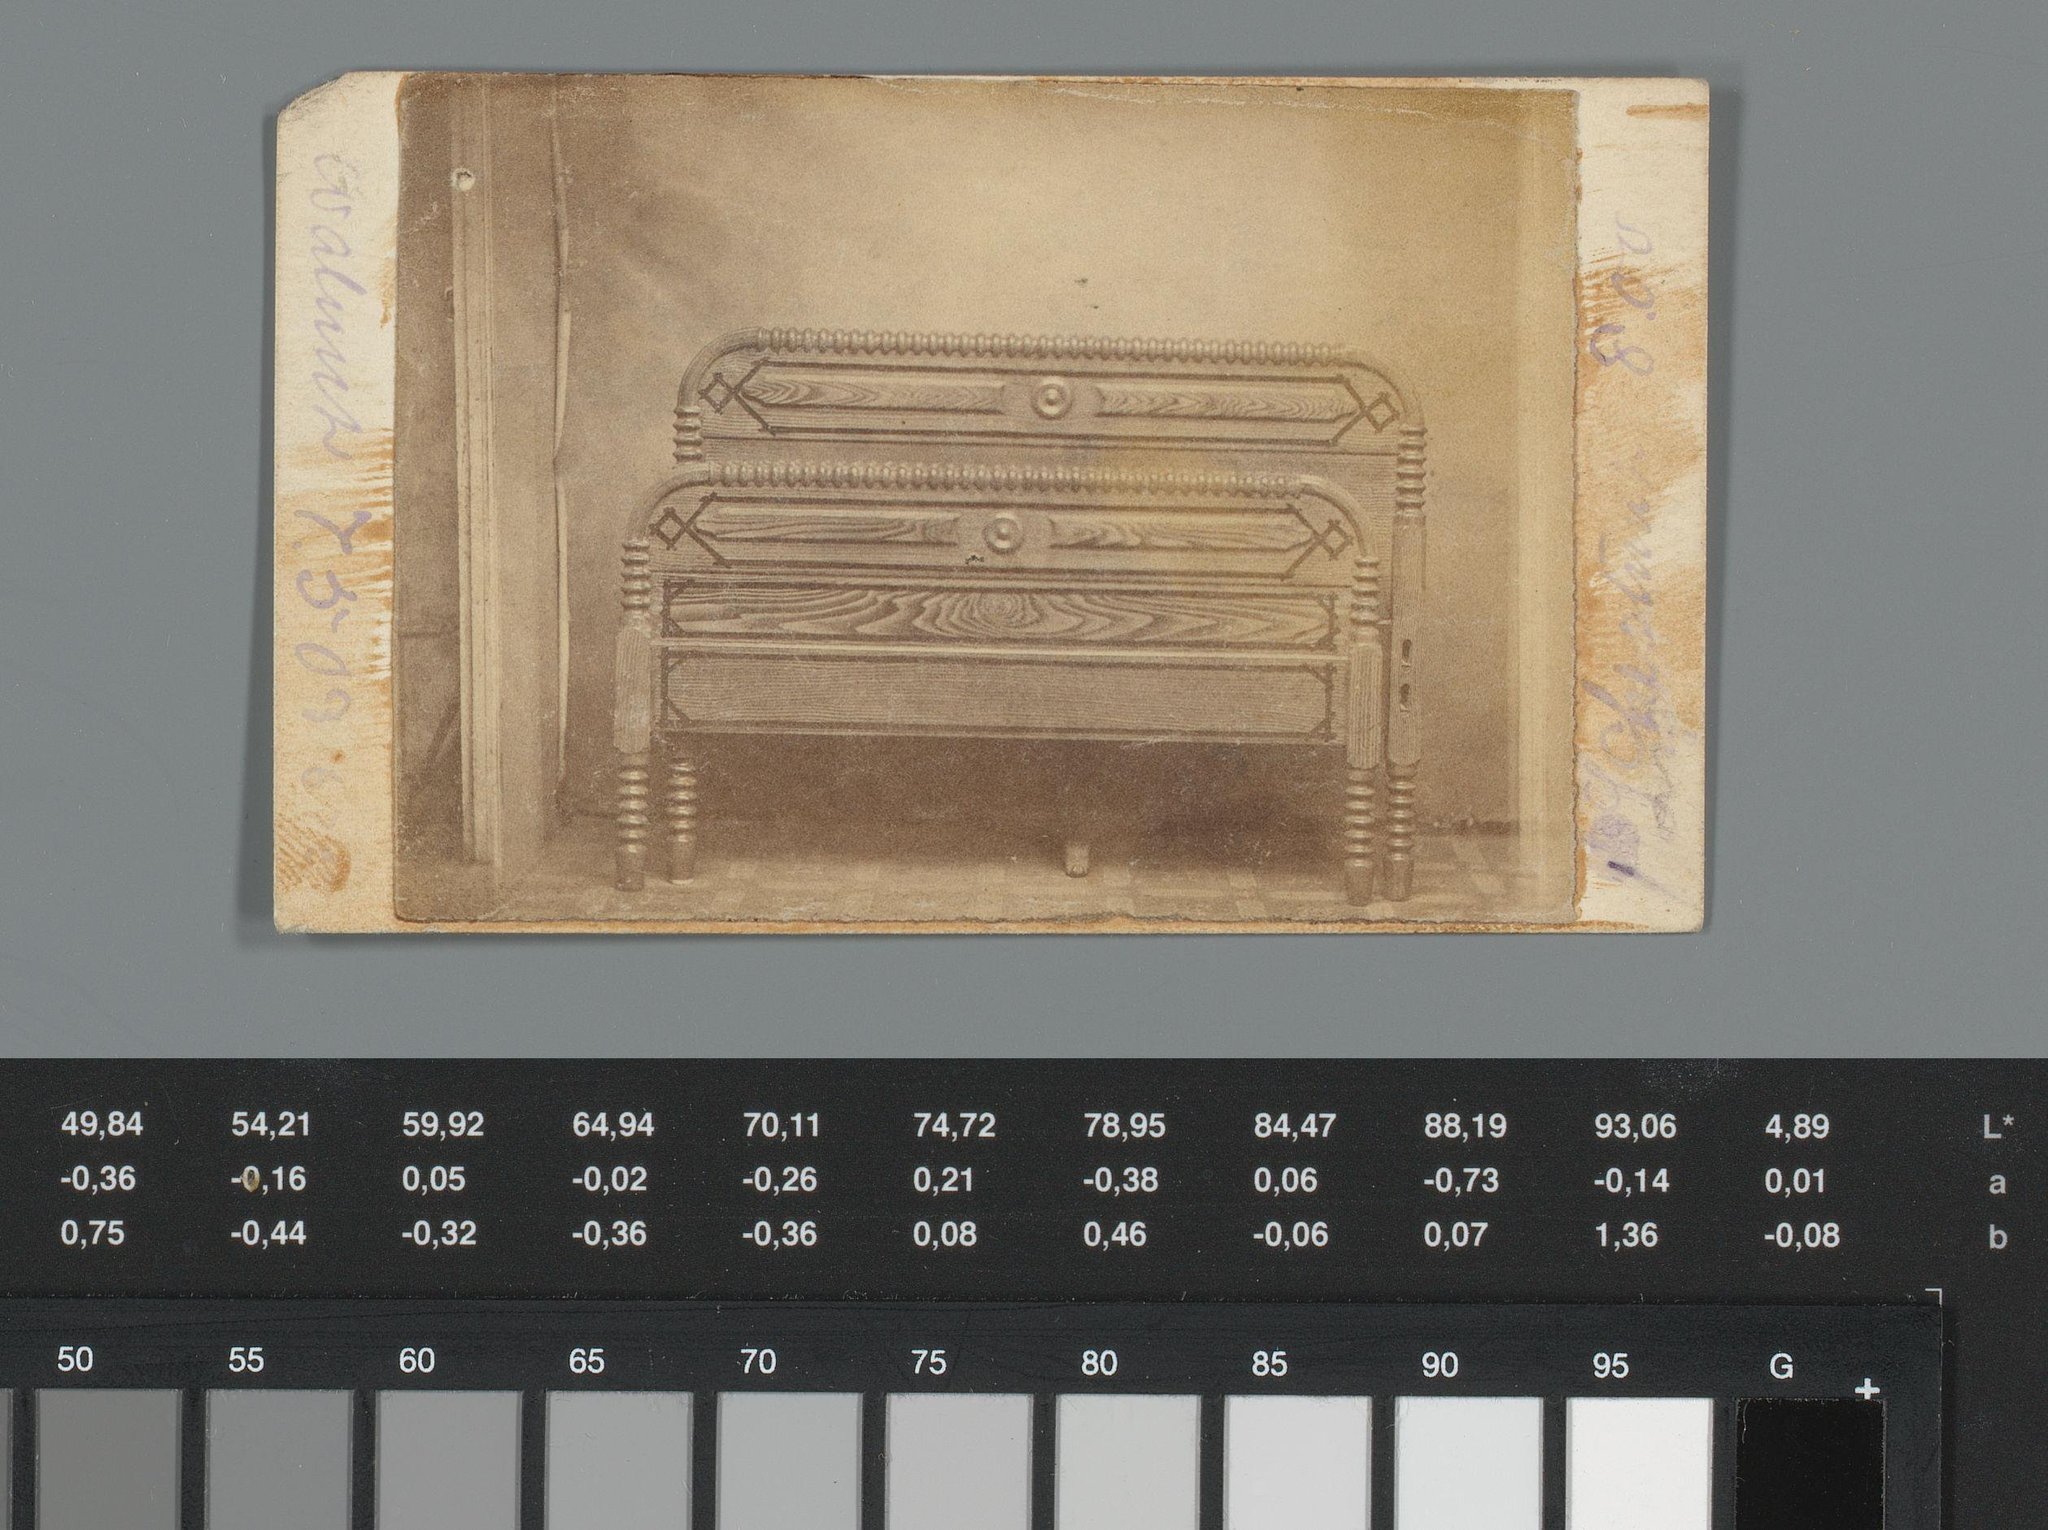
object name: photograph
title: Reclame voor een meubelstuk van L. W. Bishop in Whitney Point, New York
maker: Anonymous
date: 1850-1915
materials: cardboard, photographic support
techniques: albumen print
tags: advertising, furniture and household effects, new york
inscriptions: inscription: ‘(...)’